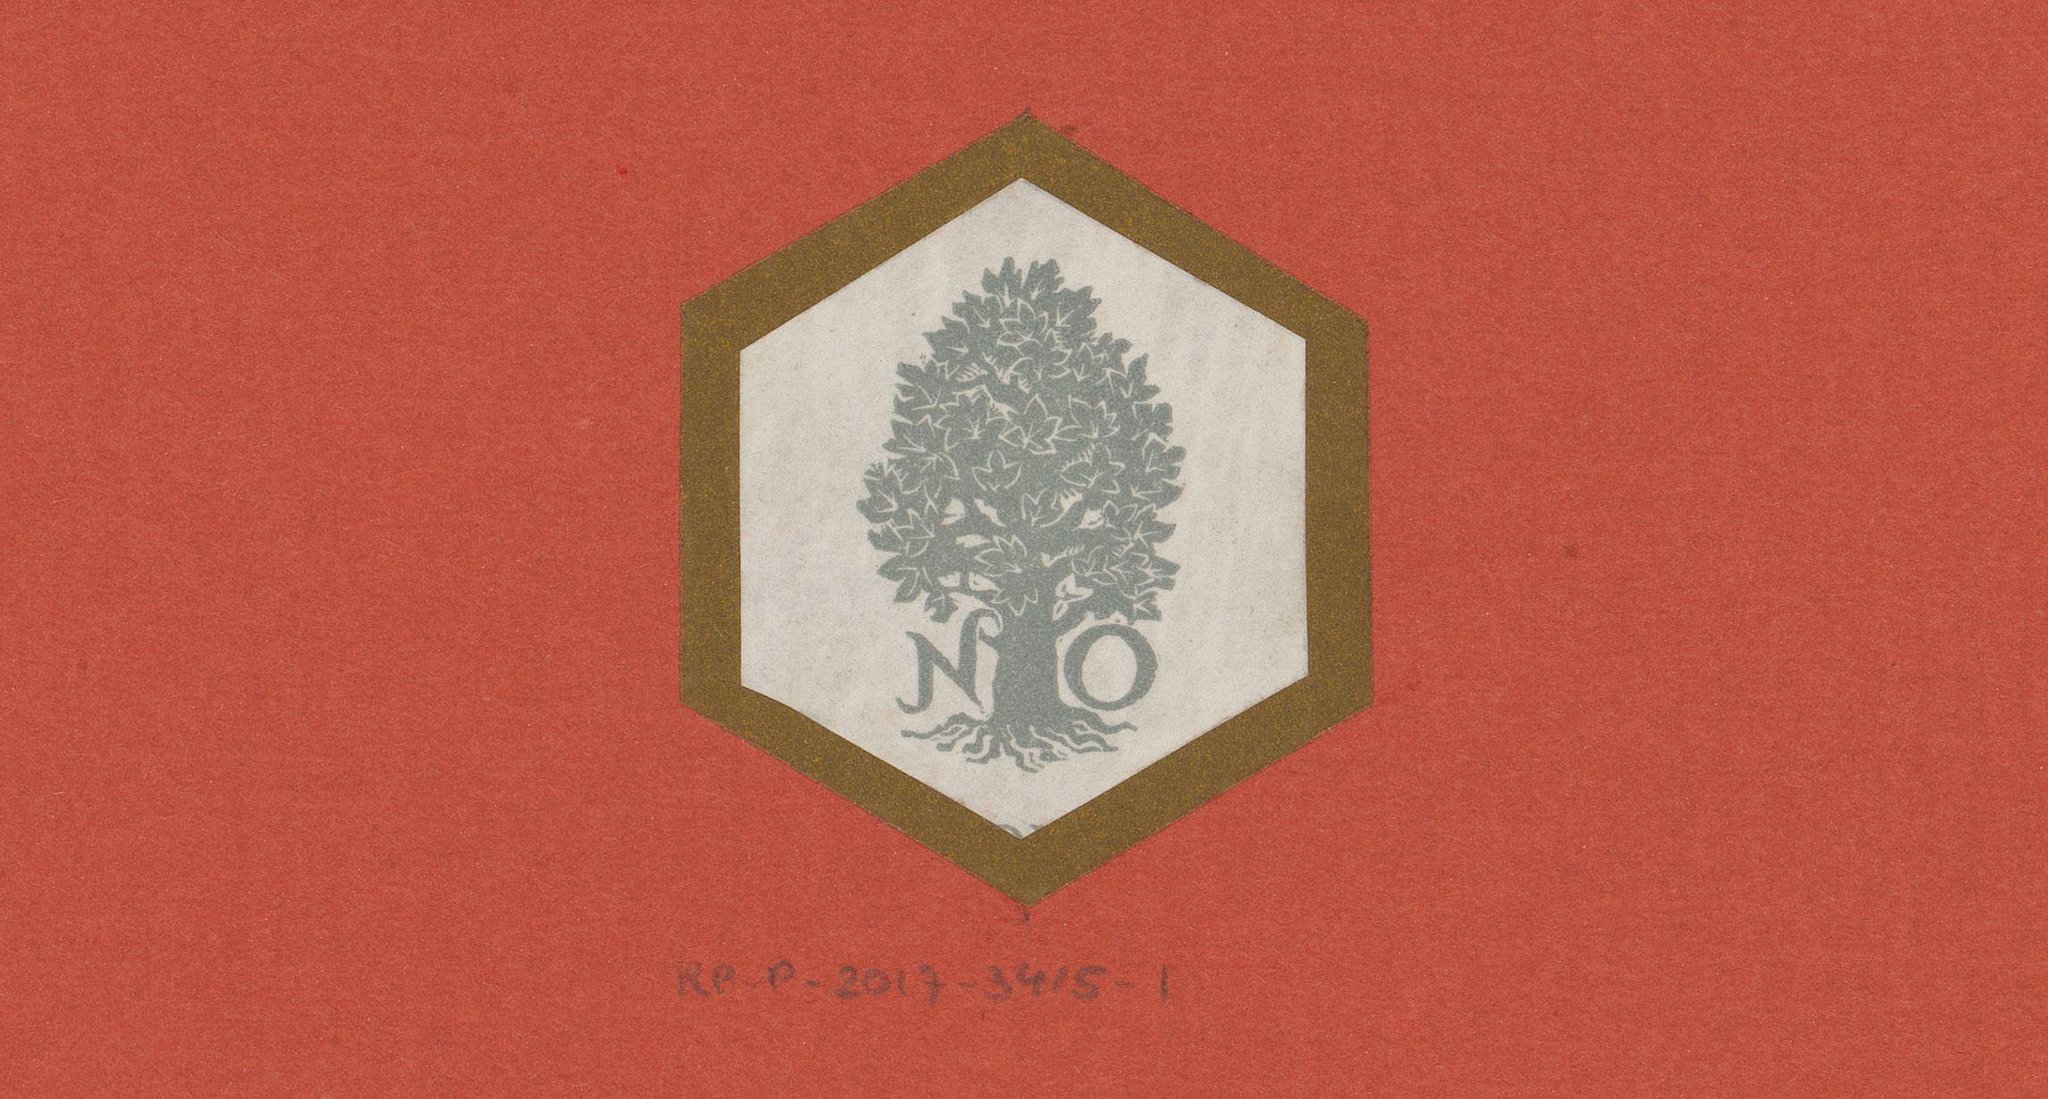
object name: bookplate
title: Ex libris van Nini Rueter-Oldenboom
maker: pam georg rueter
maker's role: print maker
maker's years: 1906-1998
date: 1916-1998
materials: paper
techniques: engraving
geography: netherlands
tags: trees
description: Prent maakt deel uit van een album met 70 ex libris.